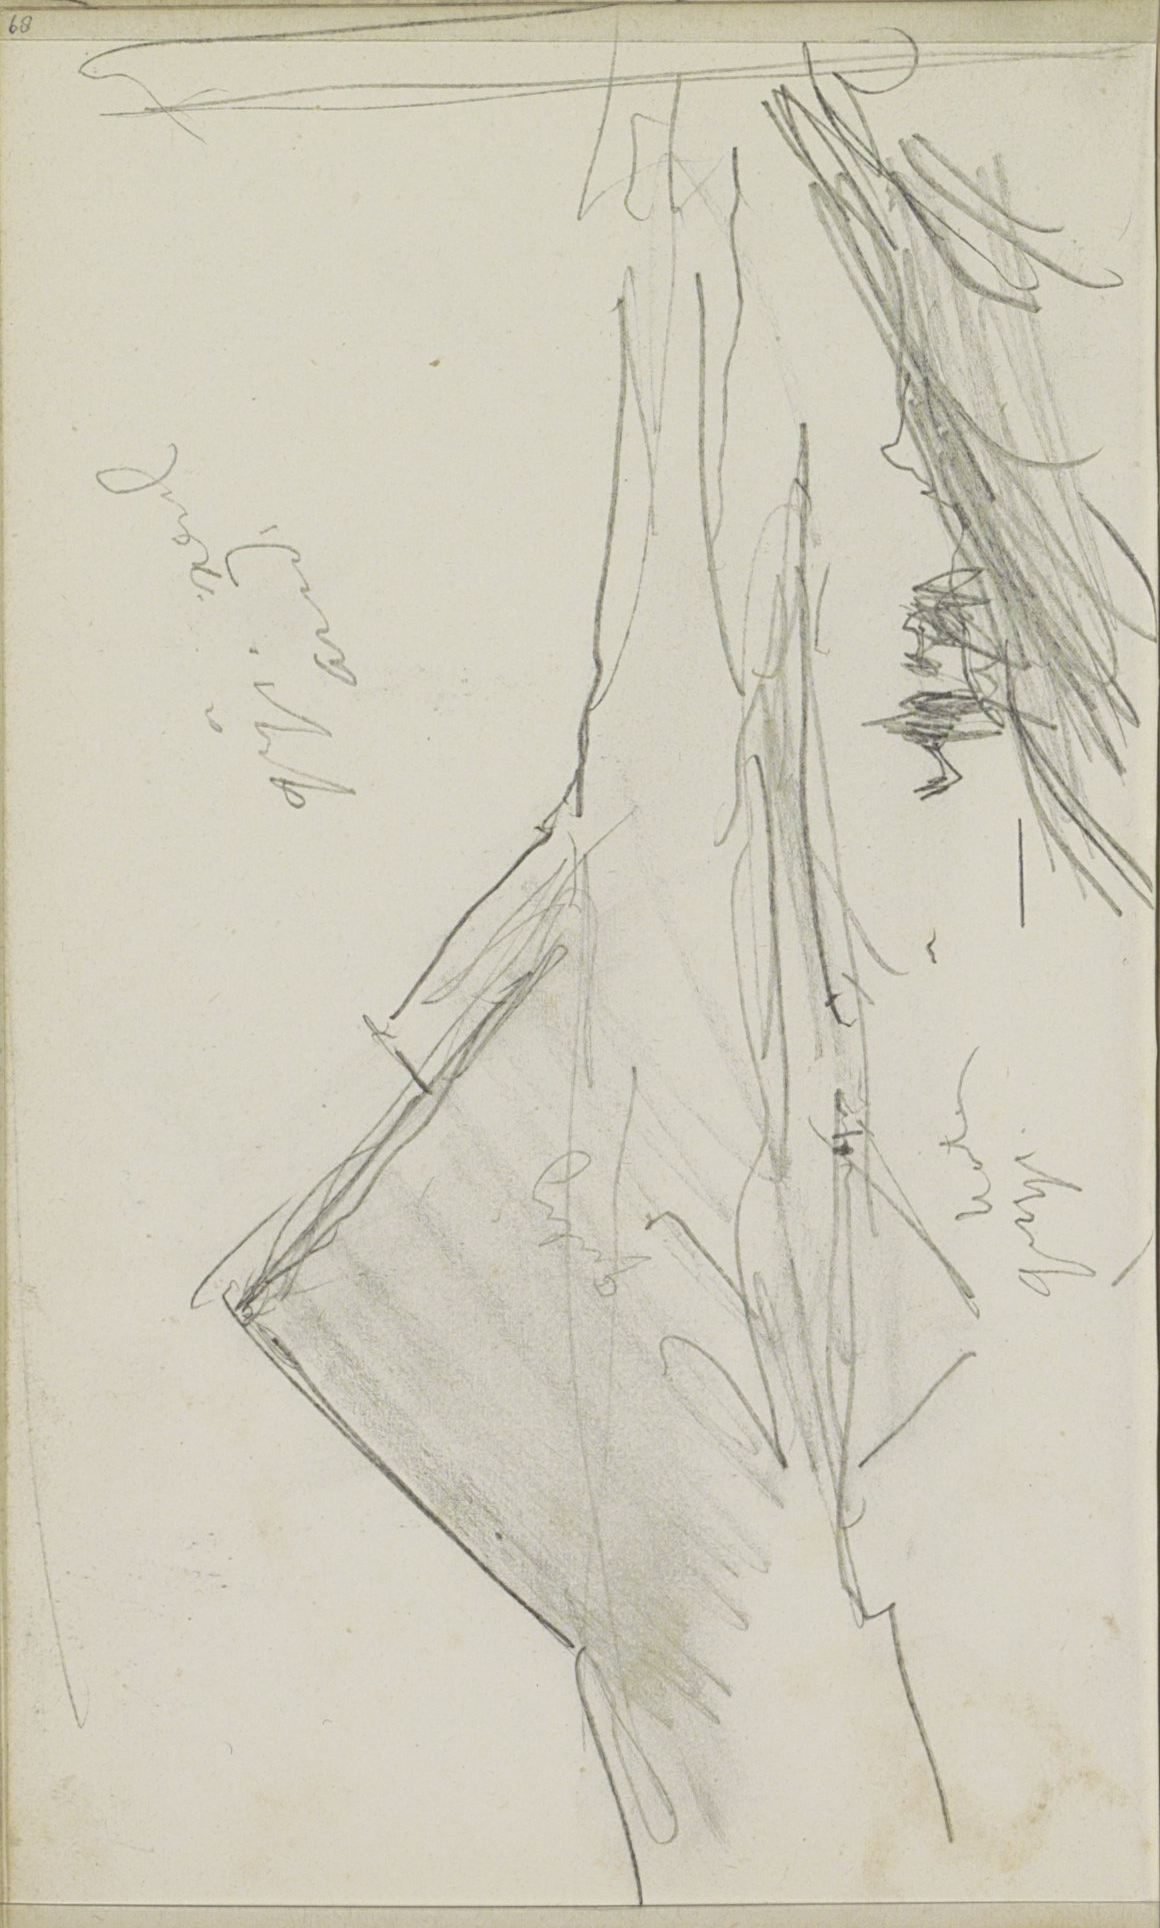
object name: sketchbook leaf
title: Piramides van Gizeh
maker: marius bauer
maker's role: draughtsman, print maker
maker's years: 1867-1932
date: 1904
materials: paper, pencil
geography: gizeh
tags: egyptian pyramids (wonder of the world), desert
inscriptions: kleurnotitie, handgeschreven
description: Pagina 68 uit een schetsboek met 56 bladen.